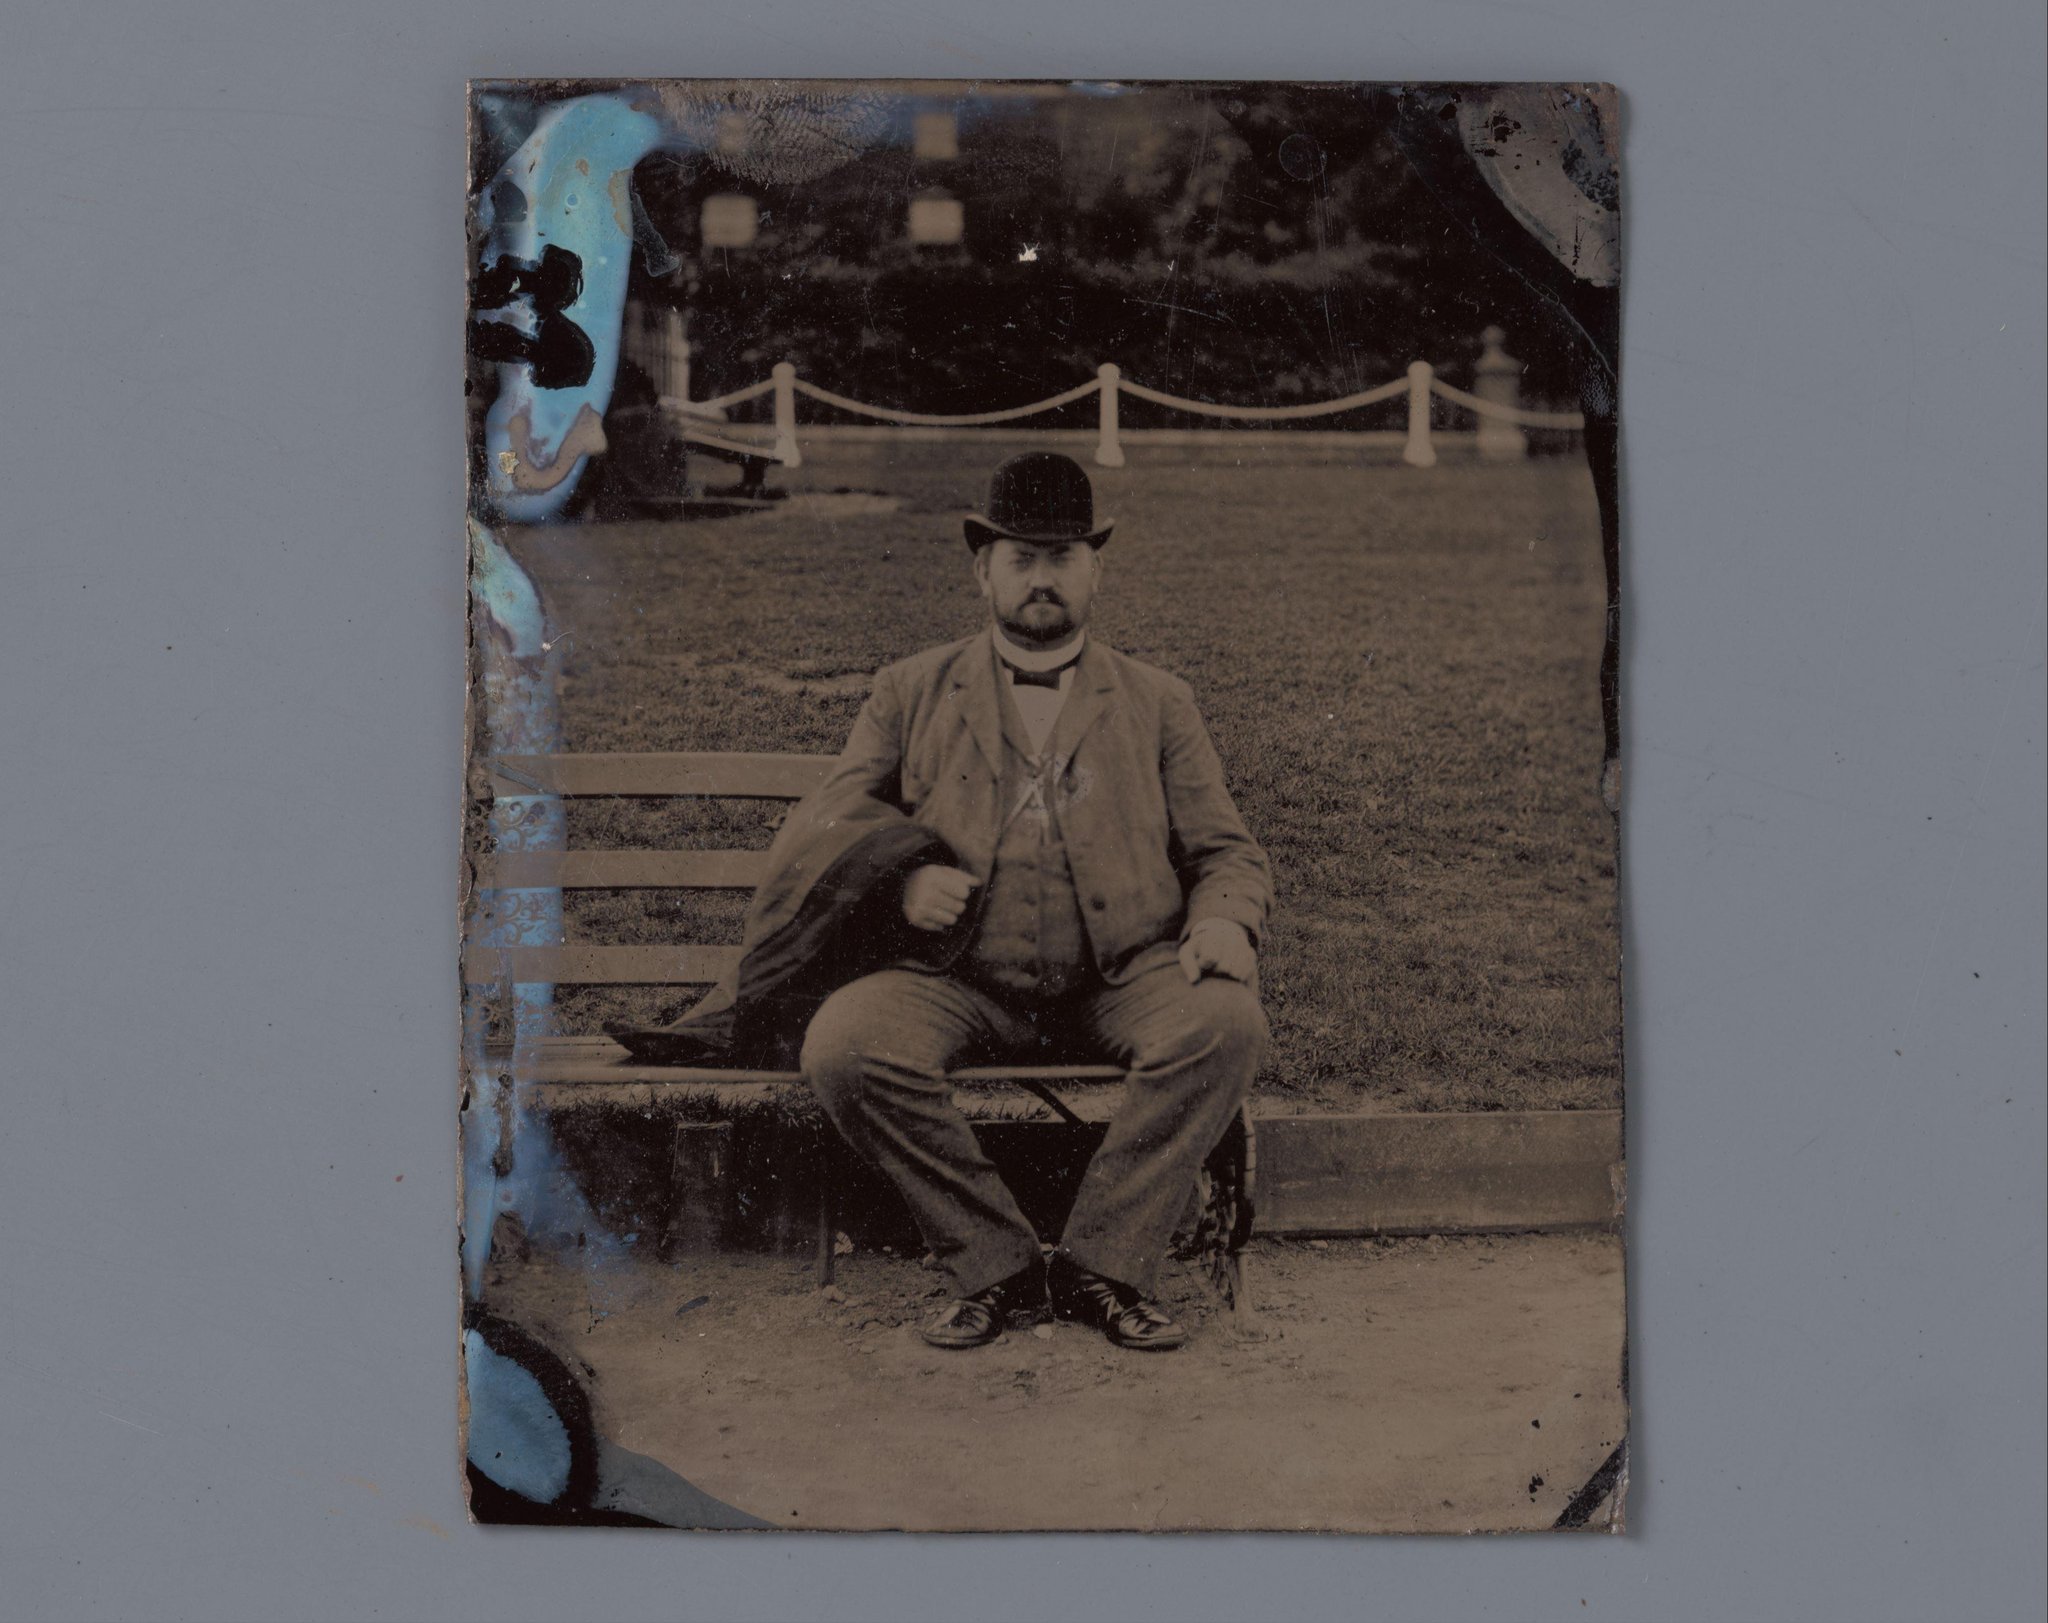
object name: photograph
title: Portret van een onbekende man op een bank in een park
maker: Anonymous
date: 1855-1940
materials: iron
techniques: ferrotyping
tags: park, sitting figure, historical persons